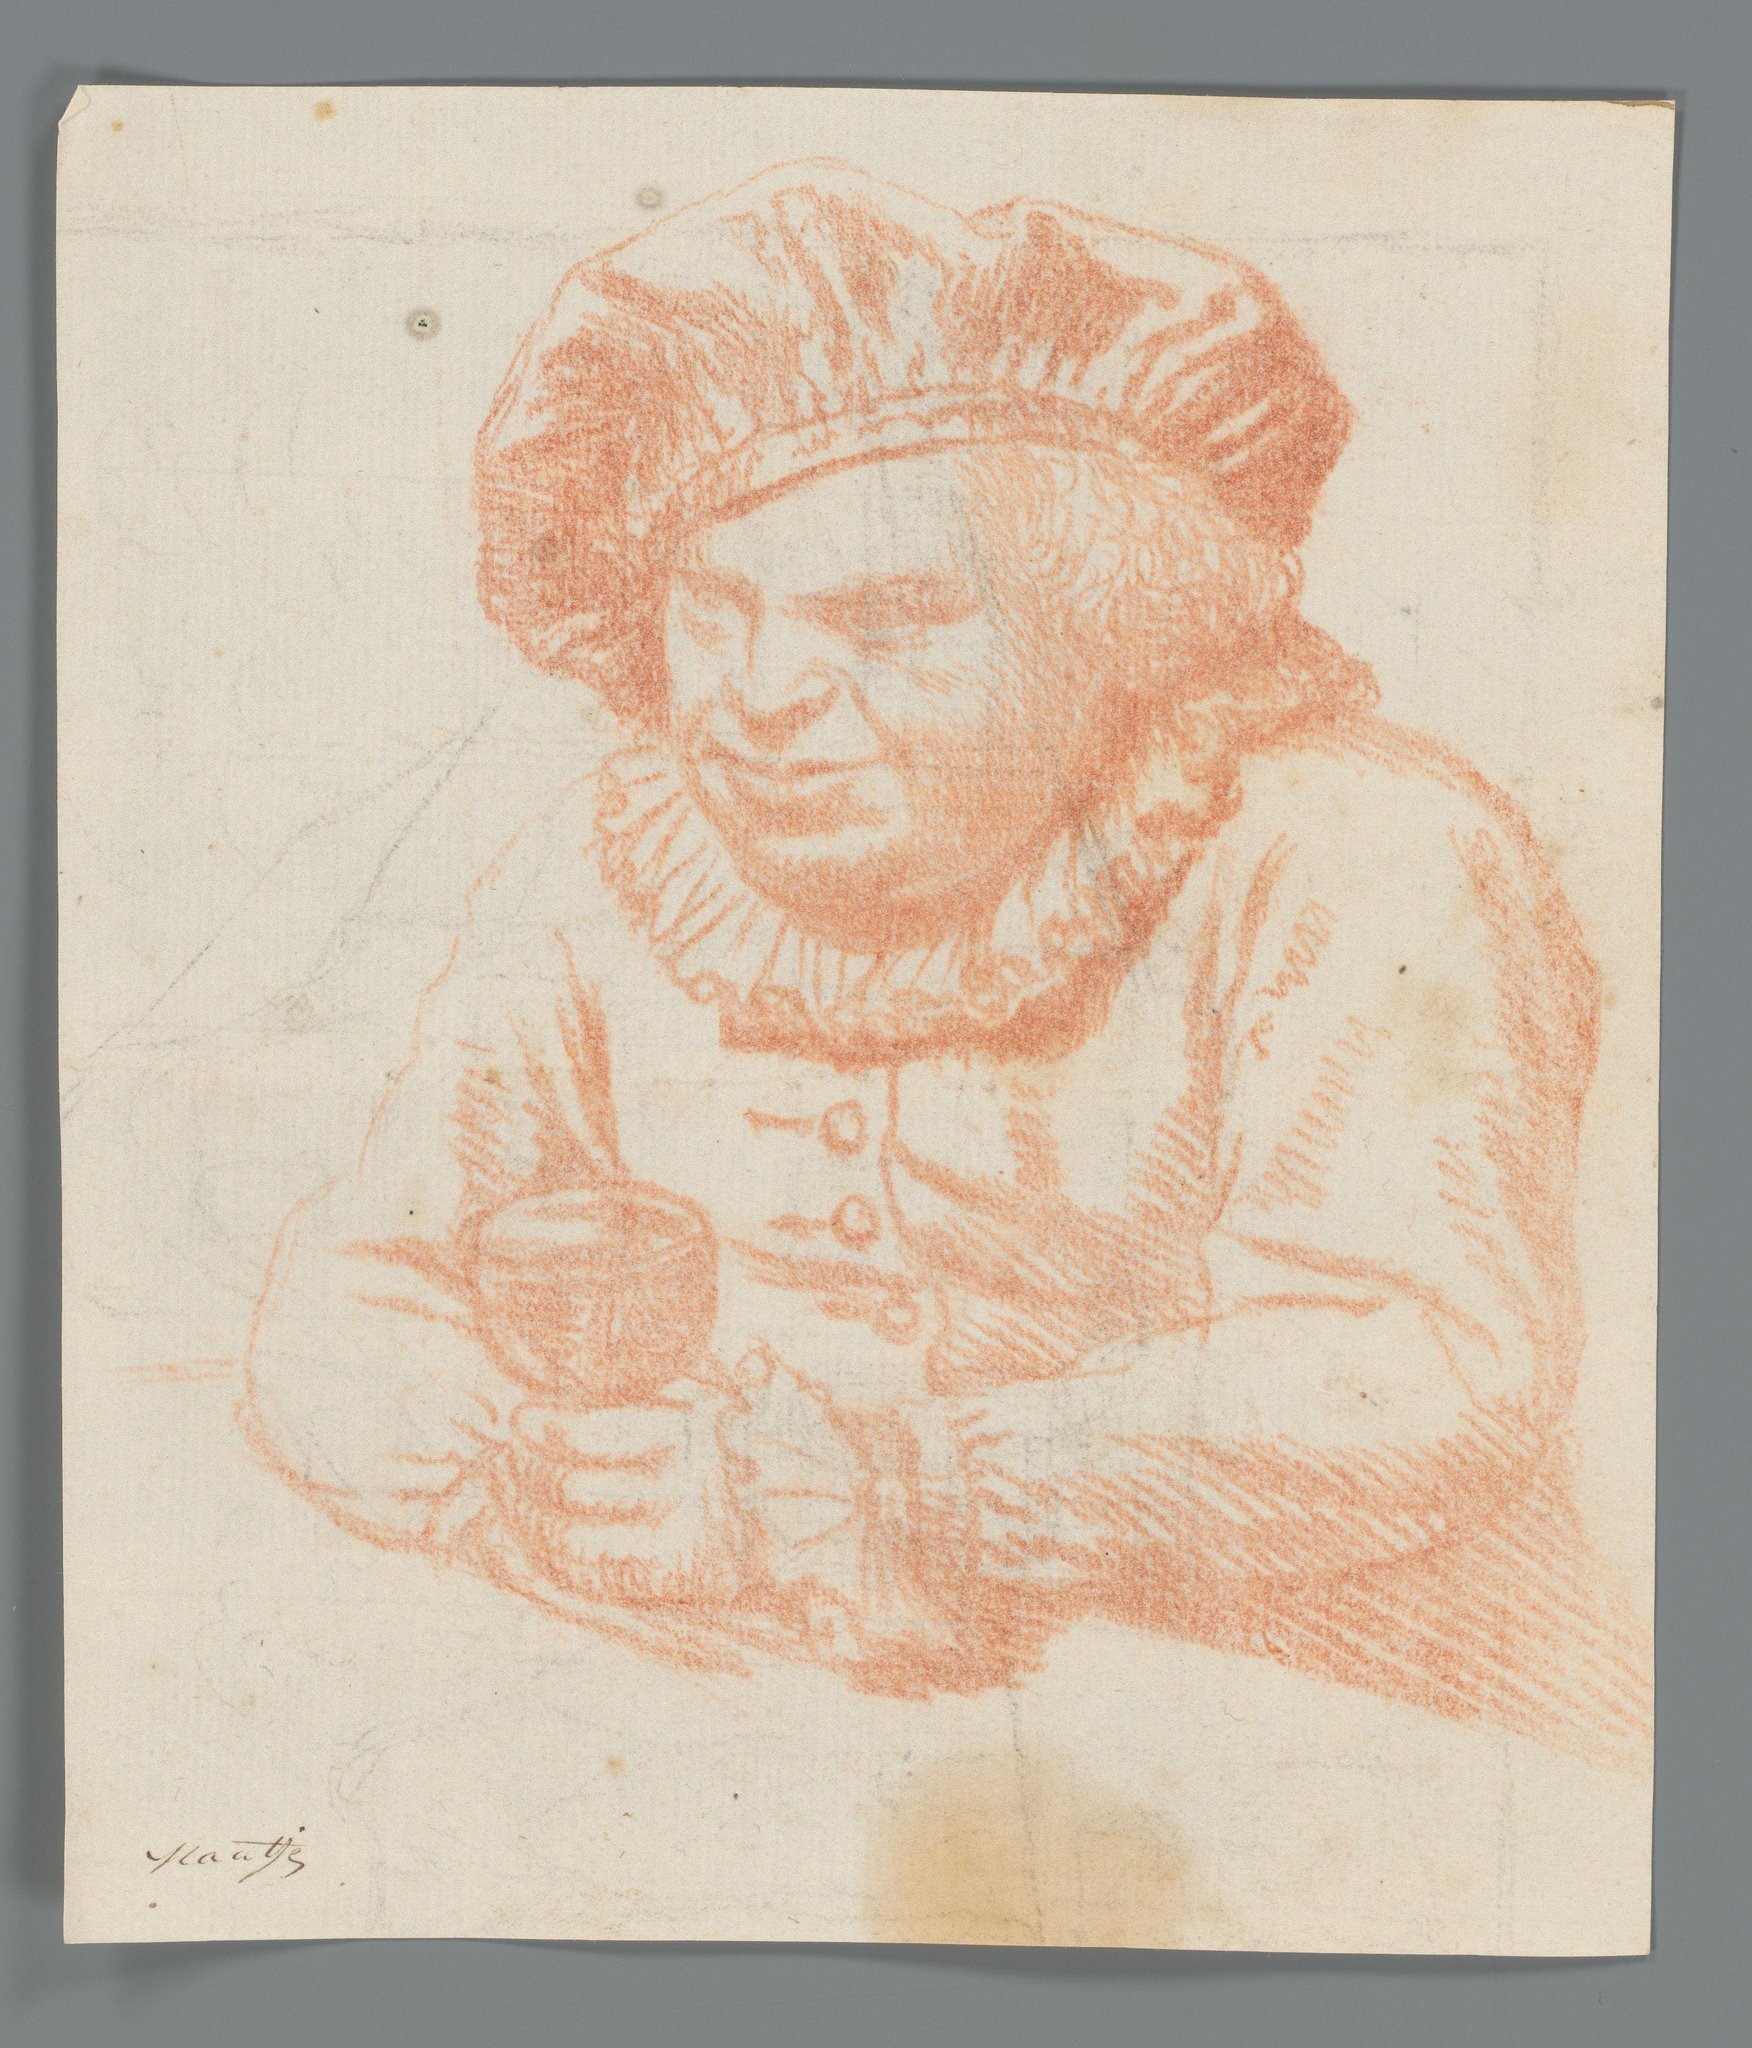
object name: drawing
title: Tronie van een man met hoed en wijnglas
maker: matthijs balen (1684-1766)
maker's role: draughtsman, painter, print maker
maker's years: 1684-1766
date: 1694-1766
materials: chalk, paper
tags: adult man, glass, rummer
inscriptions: inscription: ‘Paatje (?)’